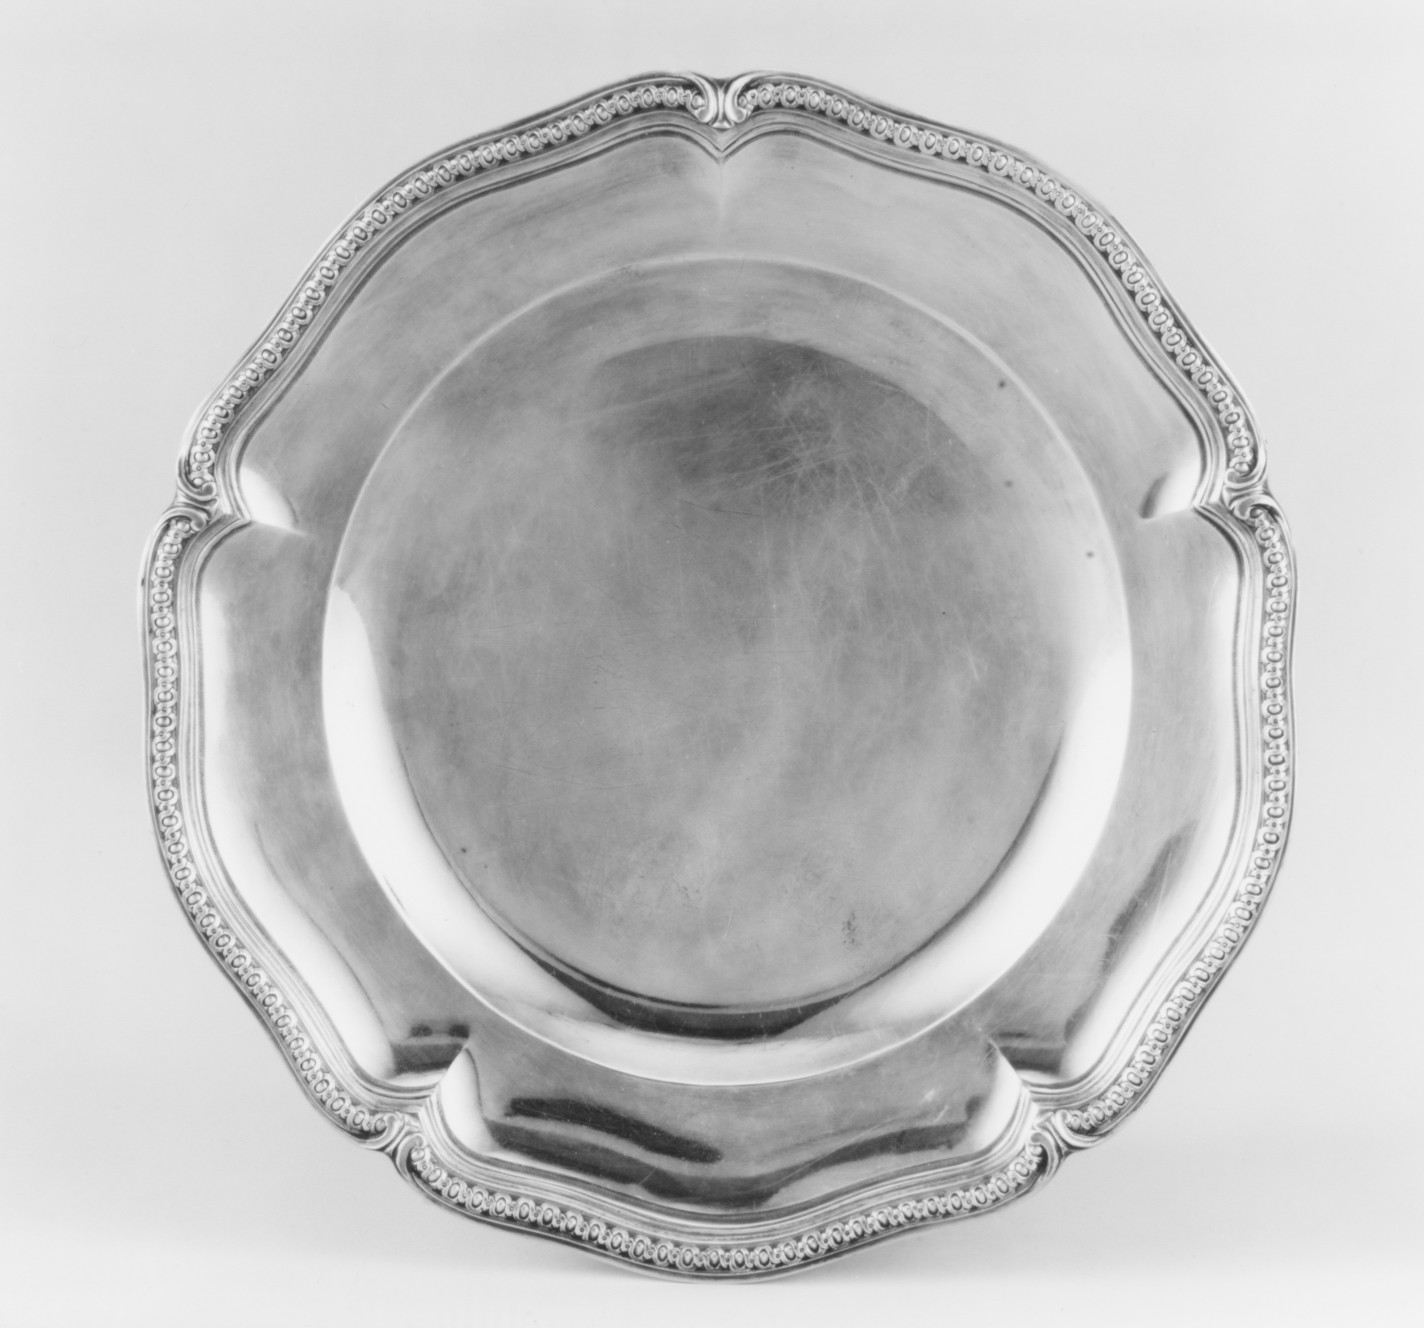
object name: plate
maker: marc-antoine-noel leroy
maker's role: maker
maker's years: 1738-1838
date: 1771-1772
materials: silver